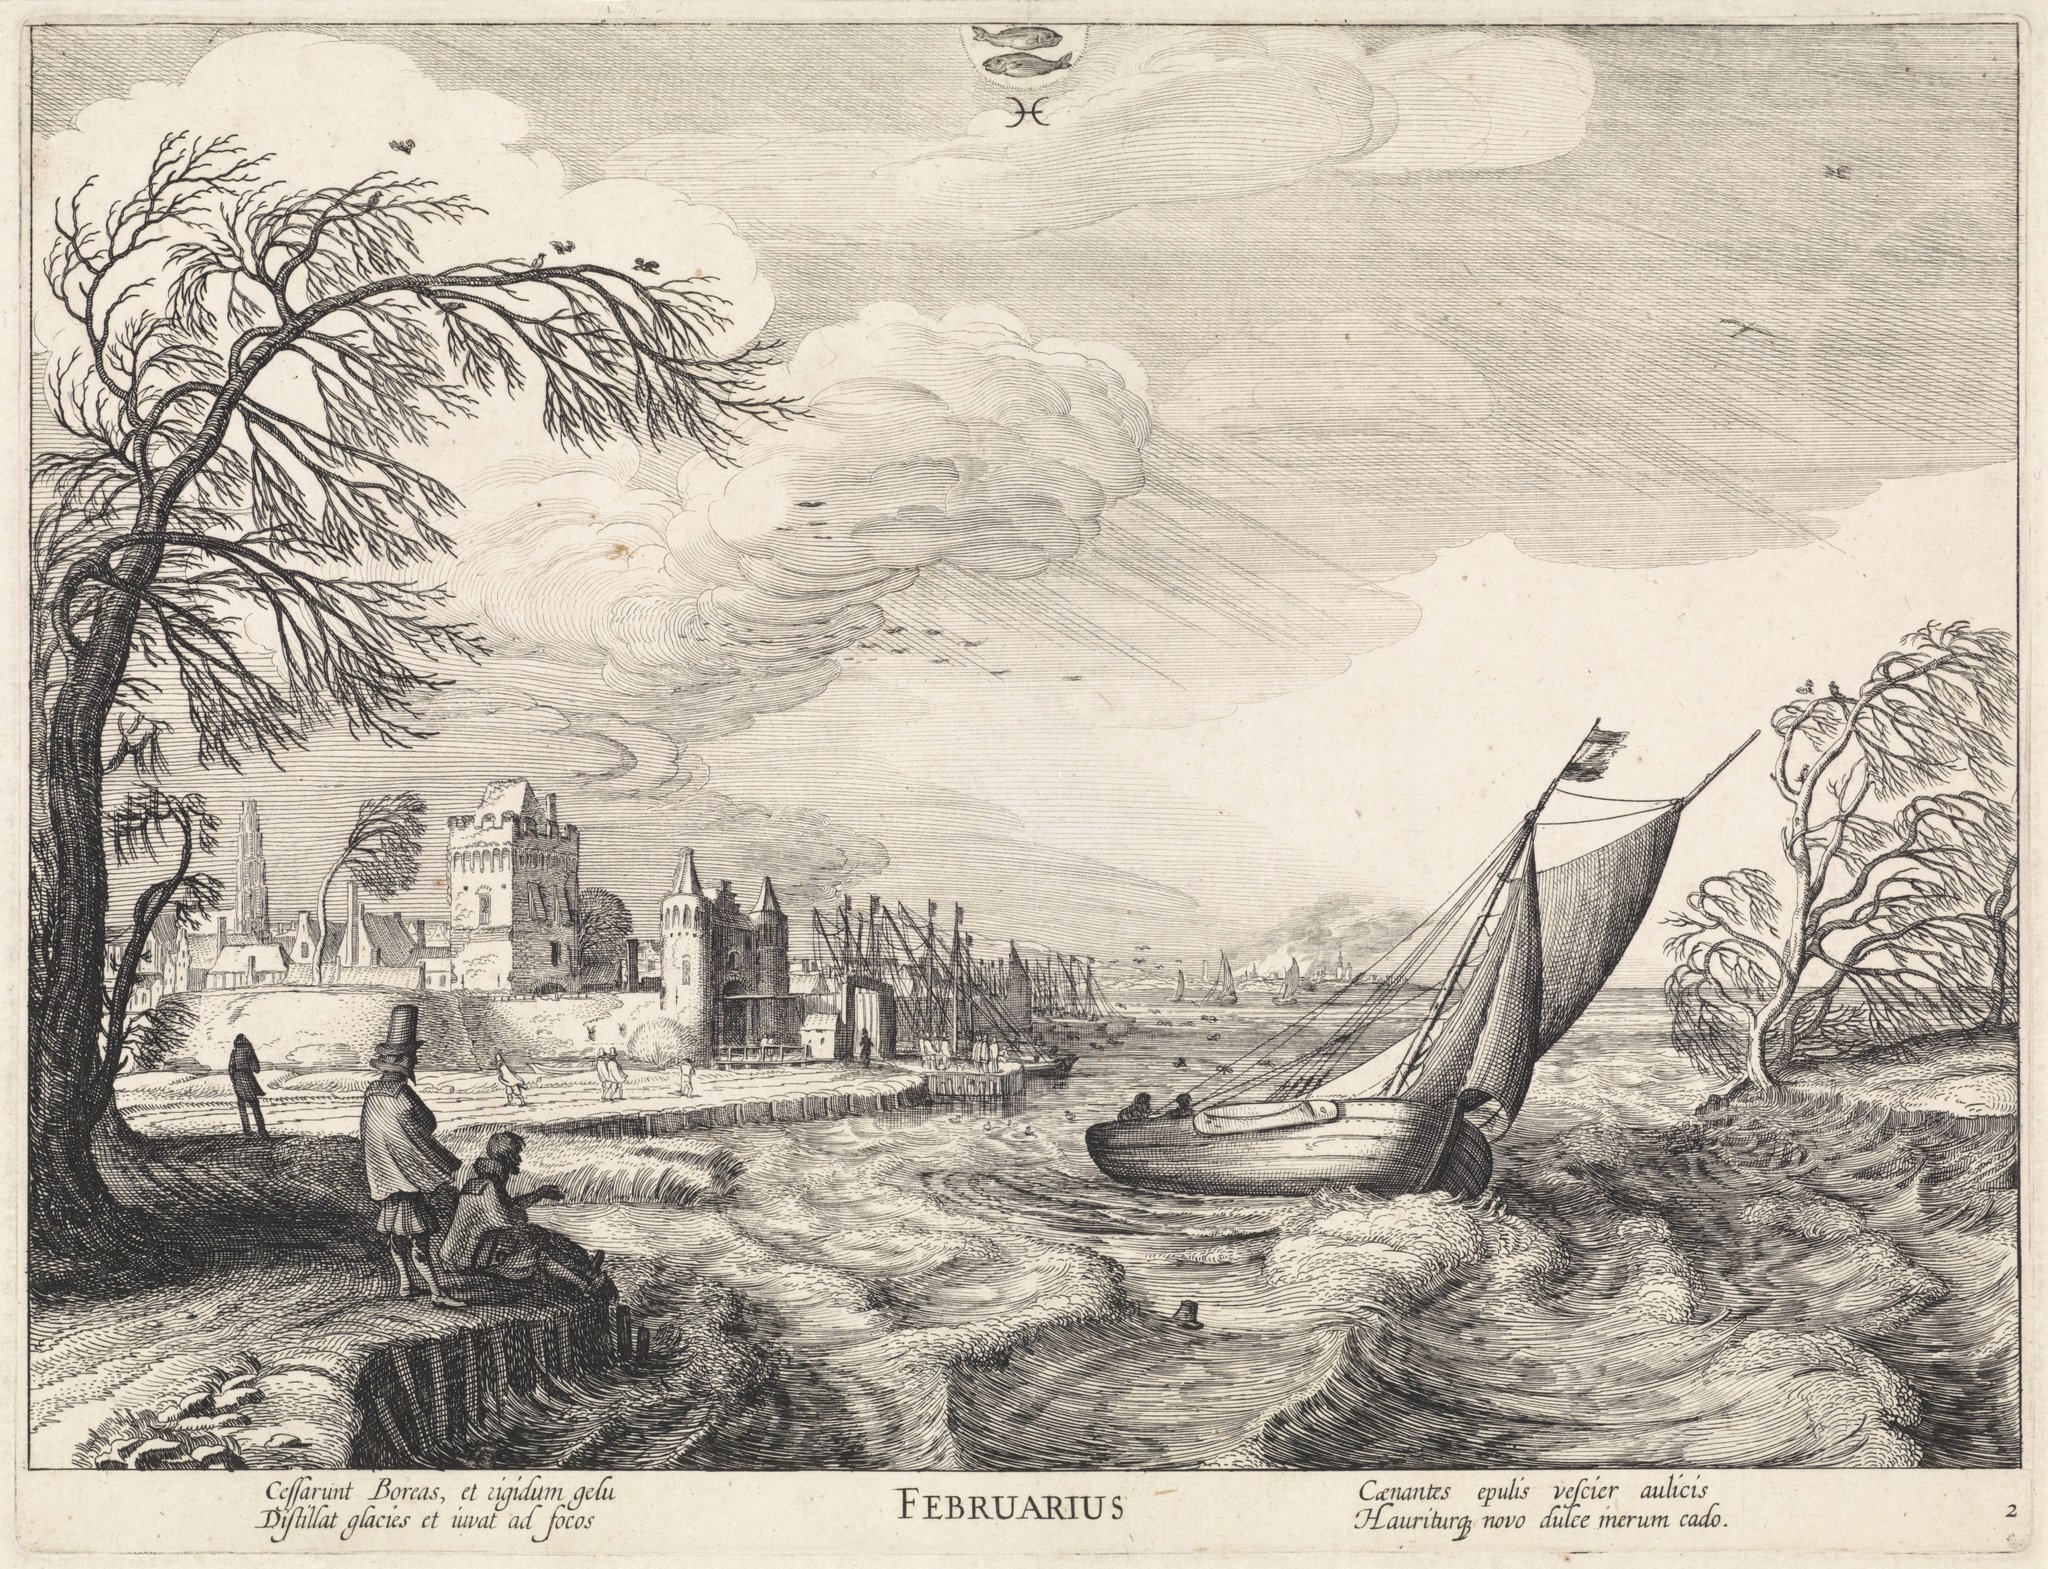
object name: print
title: Februarius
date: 1618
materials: paper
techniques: etching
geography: northern netherlands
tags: landscape symbolizing february, pisces (zodiacal sign of february), ships (in general)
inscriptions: collector's mark: Lugt 964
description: Een boot op het water bij stormachtig weer bij Kampen in de Zuiderzee, voorstellende de maand februari. Bovenaan het bij deze maand behorende sterrenbeeld: vissen. Tweede prent uit een serie van twaalf.